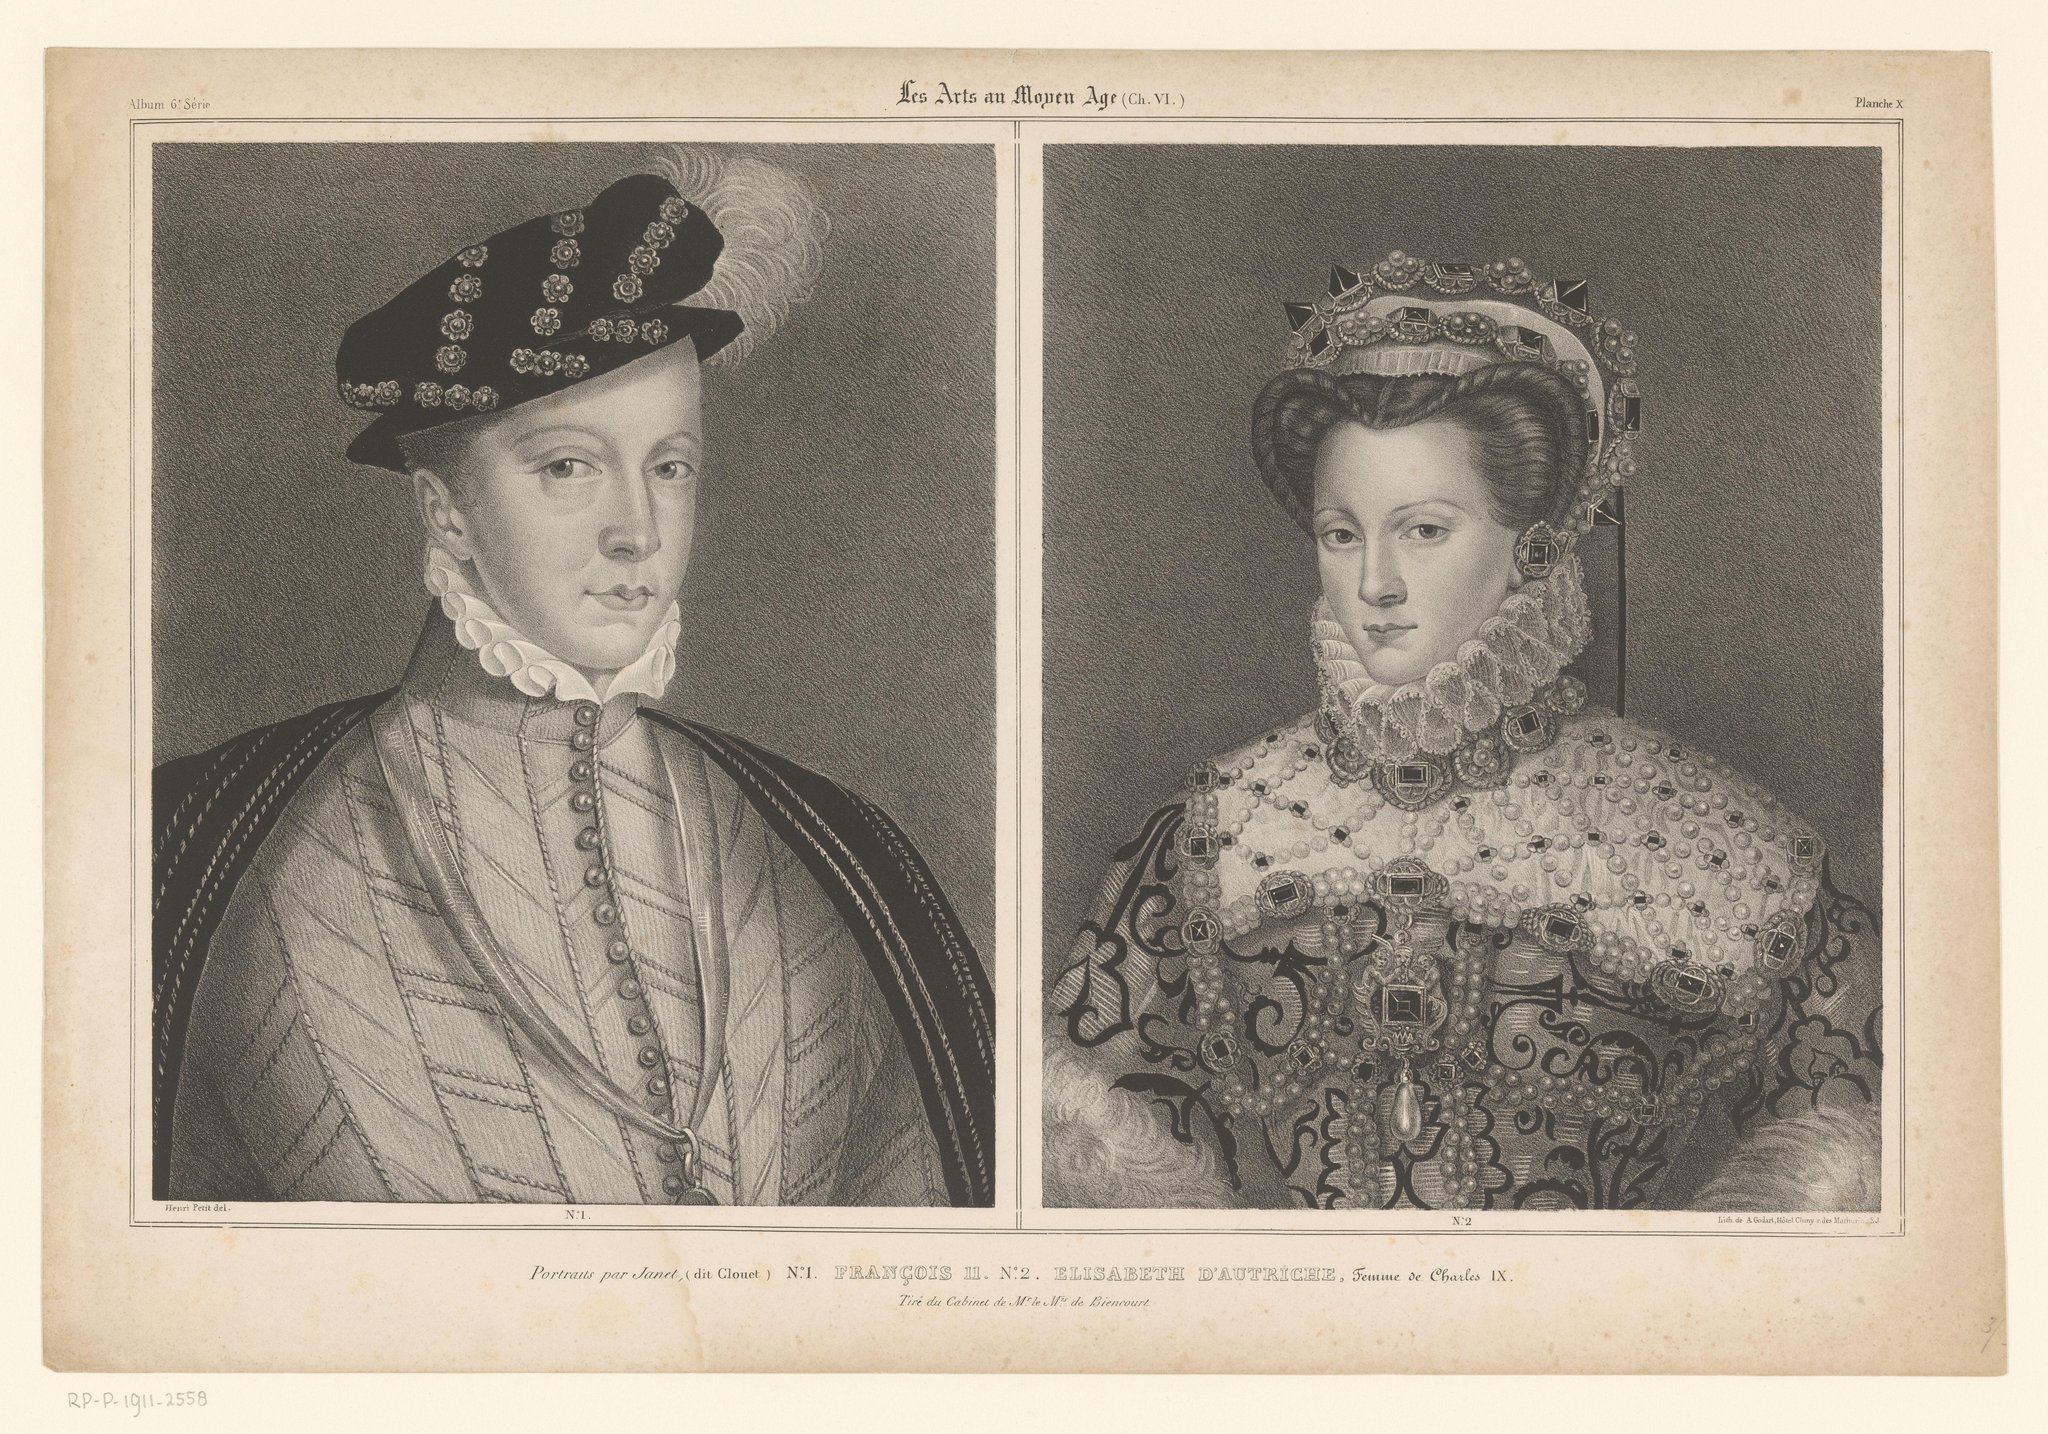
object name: print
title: Les arts au Moyen Age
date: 1838-1846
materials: paper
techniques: lithograph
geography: paris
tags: vienna, paris, fashion, clothing, historical persons, queen, king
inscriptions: check stamp: ‘deels zichtbaar’, collector's mark: Lugt 2228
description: Prent uitgegeven bij: Sommerard, Alexandre du. Les arts au Moyen Age. En ce qui concerne principalement le Palais Romain de Paris, l'Hotel de Cluun (…). 5 dln. Parijs: s.n., 1838-1846. De volledige uitgave van 'Les arts au Moyen Age' bestond uit de vijf hierboven genoemde boeken met tekst en daarbij horende prenten die los van de tekst zijn uitgegeven. De prenten zijn verdeeld onder 'L'Atlas' en 'L'Album'. 'L'Album' is onderverdeeld in tien delen met ieder 40 prenten, de huidige prent hoort bij het zesde deel. Het serienummer verwijst dus naar het nummer van deze prent binnen de 40 prenten van dat deel. In sommige gevallen is het serienummer aangepast en komt het nummer op de prent niet overeen met het nummer in het hieronder vermelde overzicht. Voor de precieze inhoud van het tekstgedeelte, 'L'Atlas' en 'L'Album', zie: Sommerard, Alexandre du. Les arts au Moyen Age. En ce qui concerne principalement le Palais Romain de Paris, l’Hotel de Cluun (…). 5 dln. Parijs: s.n., 1838-1846, dl. 5 (1846) p. 379-429.